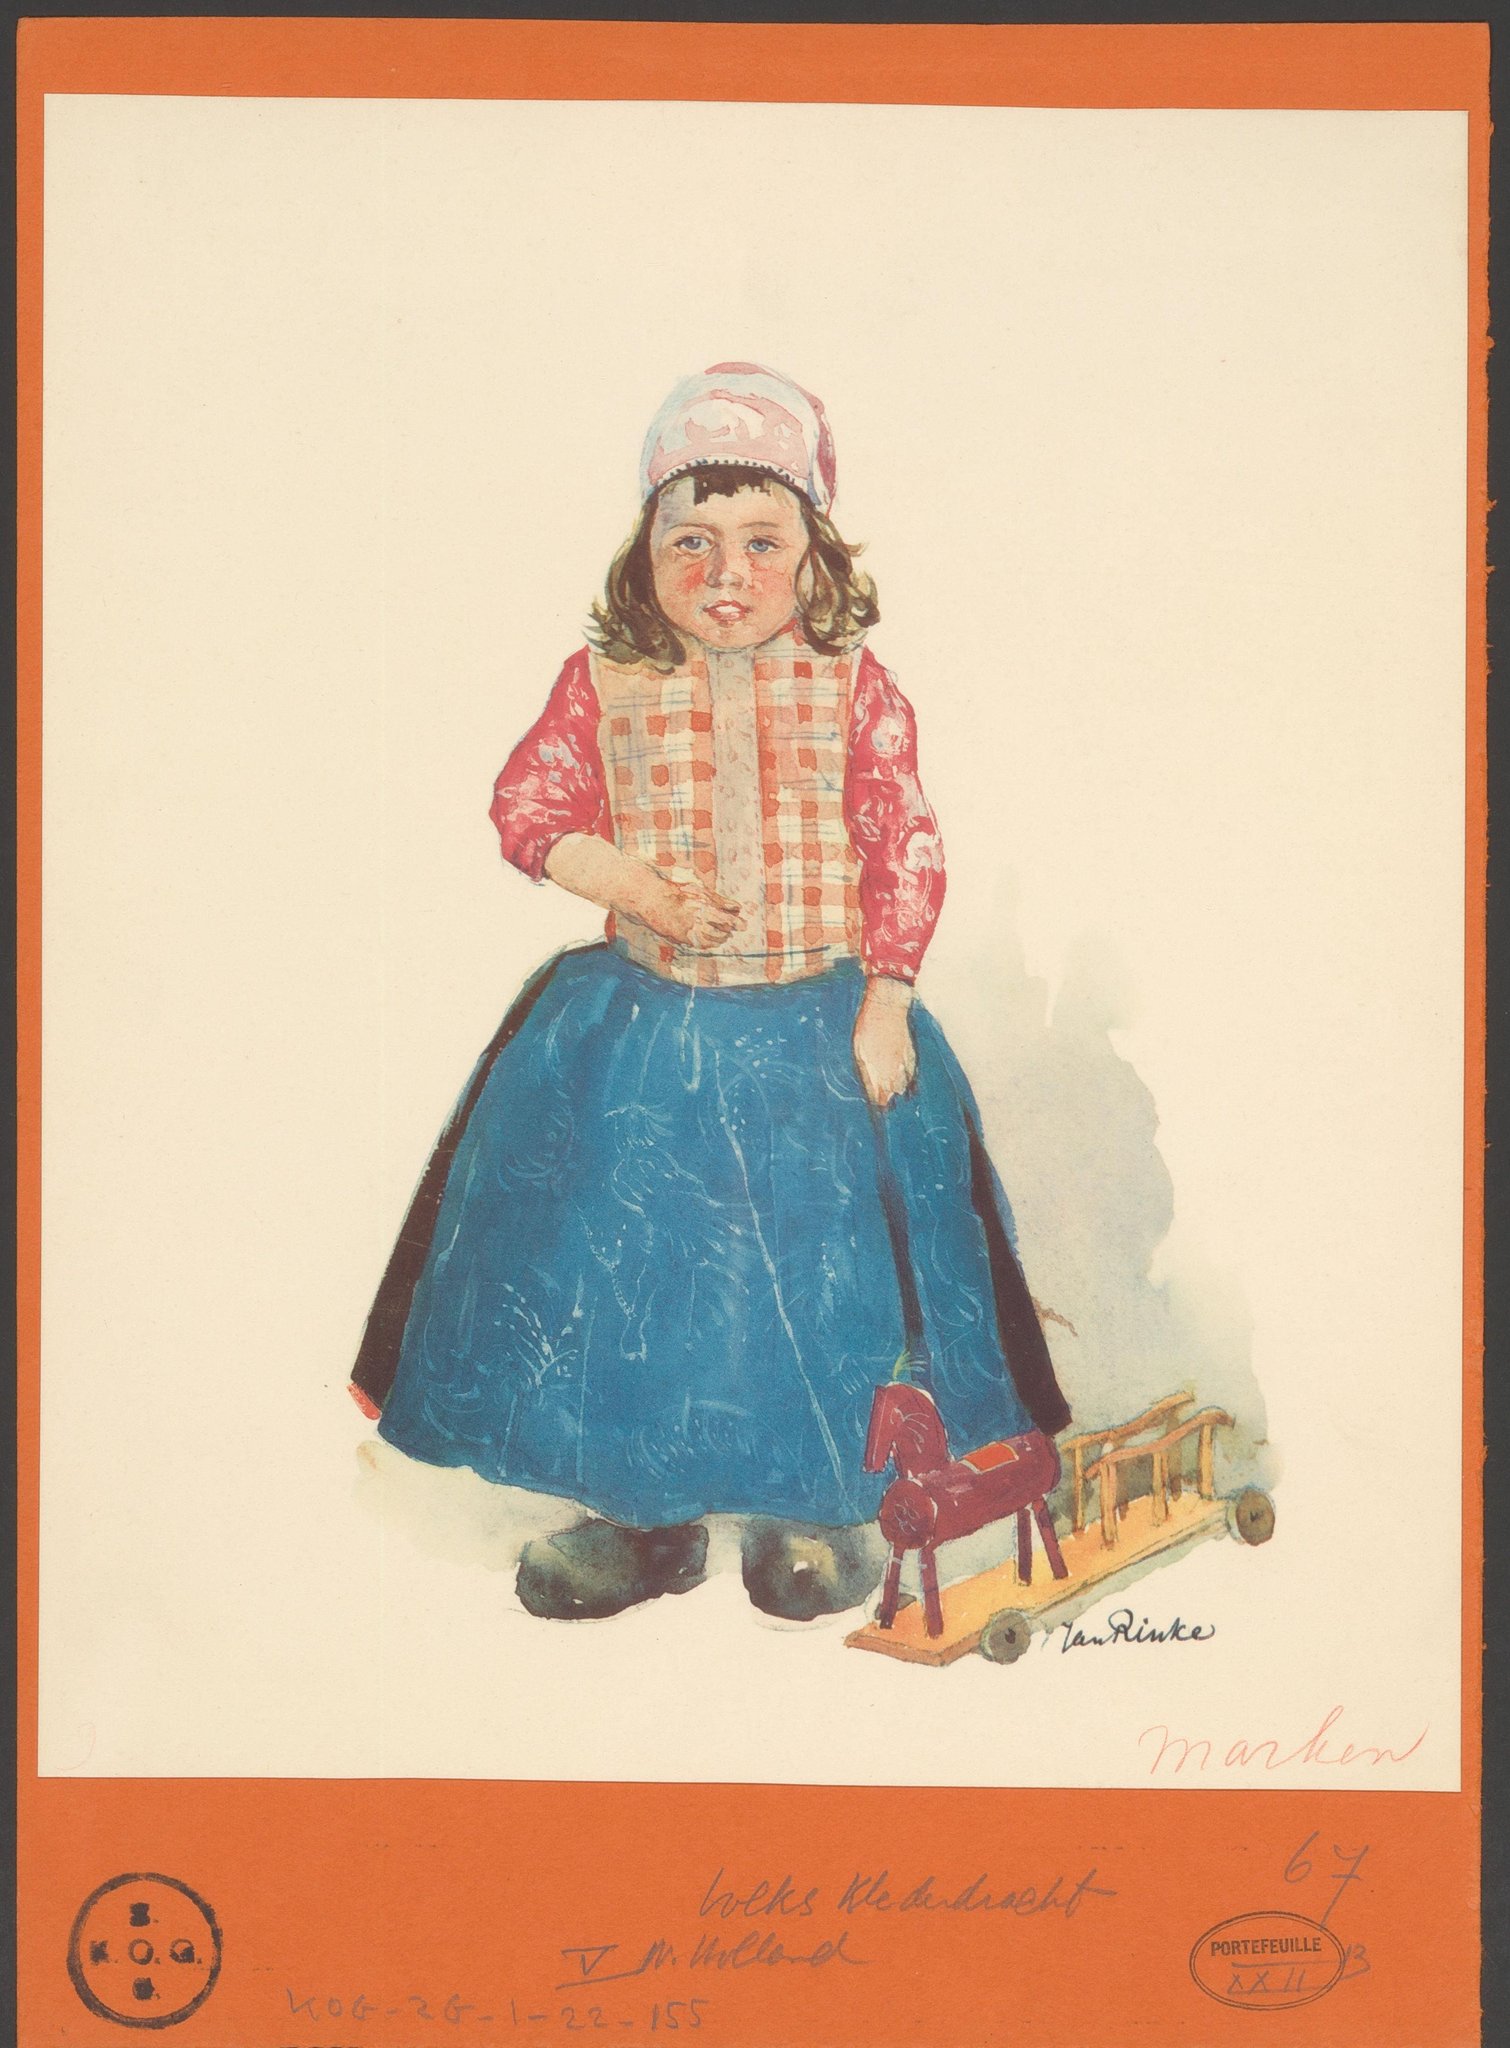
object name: photomechanical print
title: Meisje van Marken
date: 1920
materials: paper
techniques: photograph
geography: netherlands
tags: clothes, costume (+ children's clothes), folk costume, regional costume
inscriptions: collector's mark, collector's mark: Lugt 1641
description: Meisje van Marken, met speelgoed paard op wielen. Onderwerpsrubrieken binnen de Atlas Zeden en Gewoonten: De Kleeding, Volkskleederdracht, Noord-Holland.